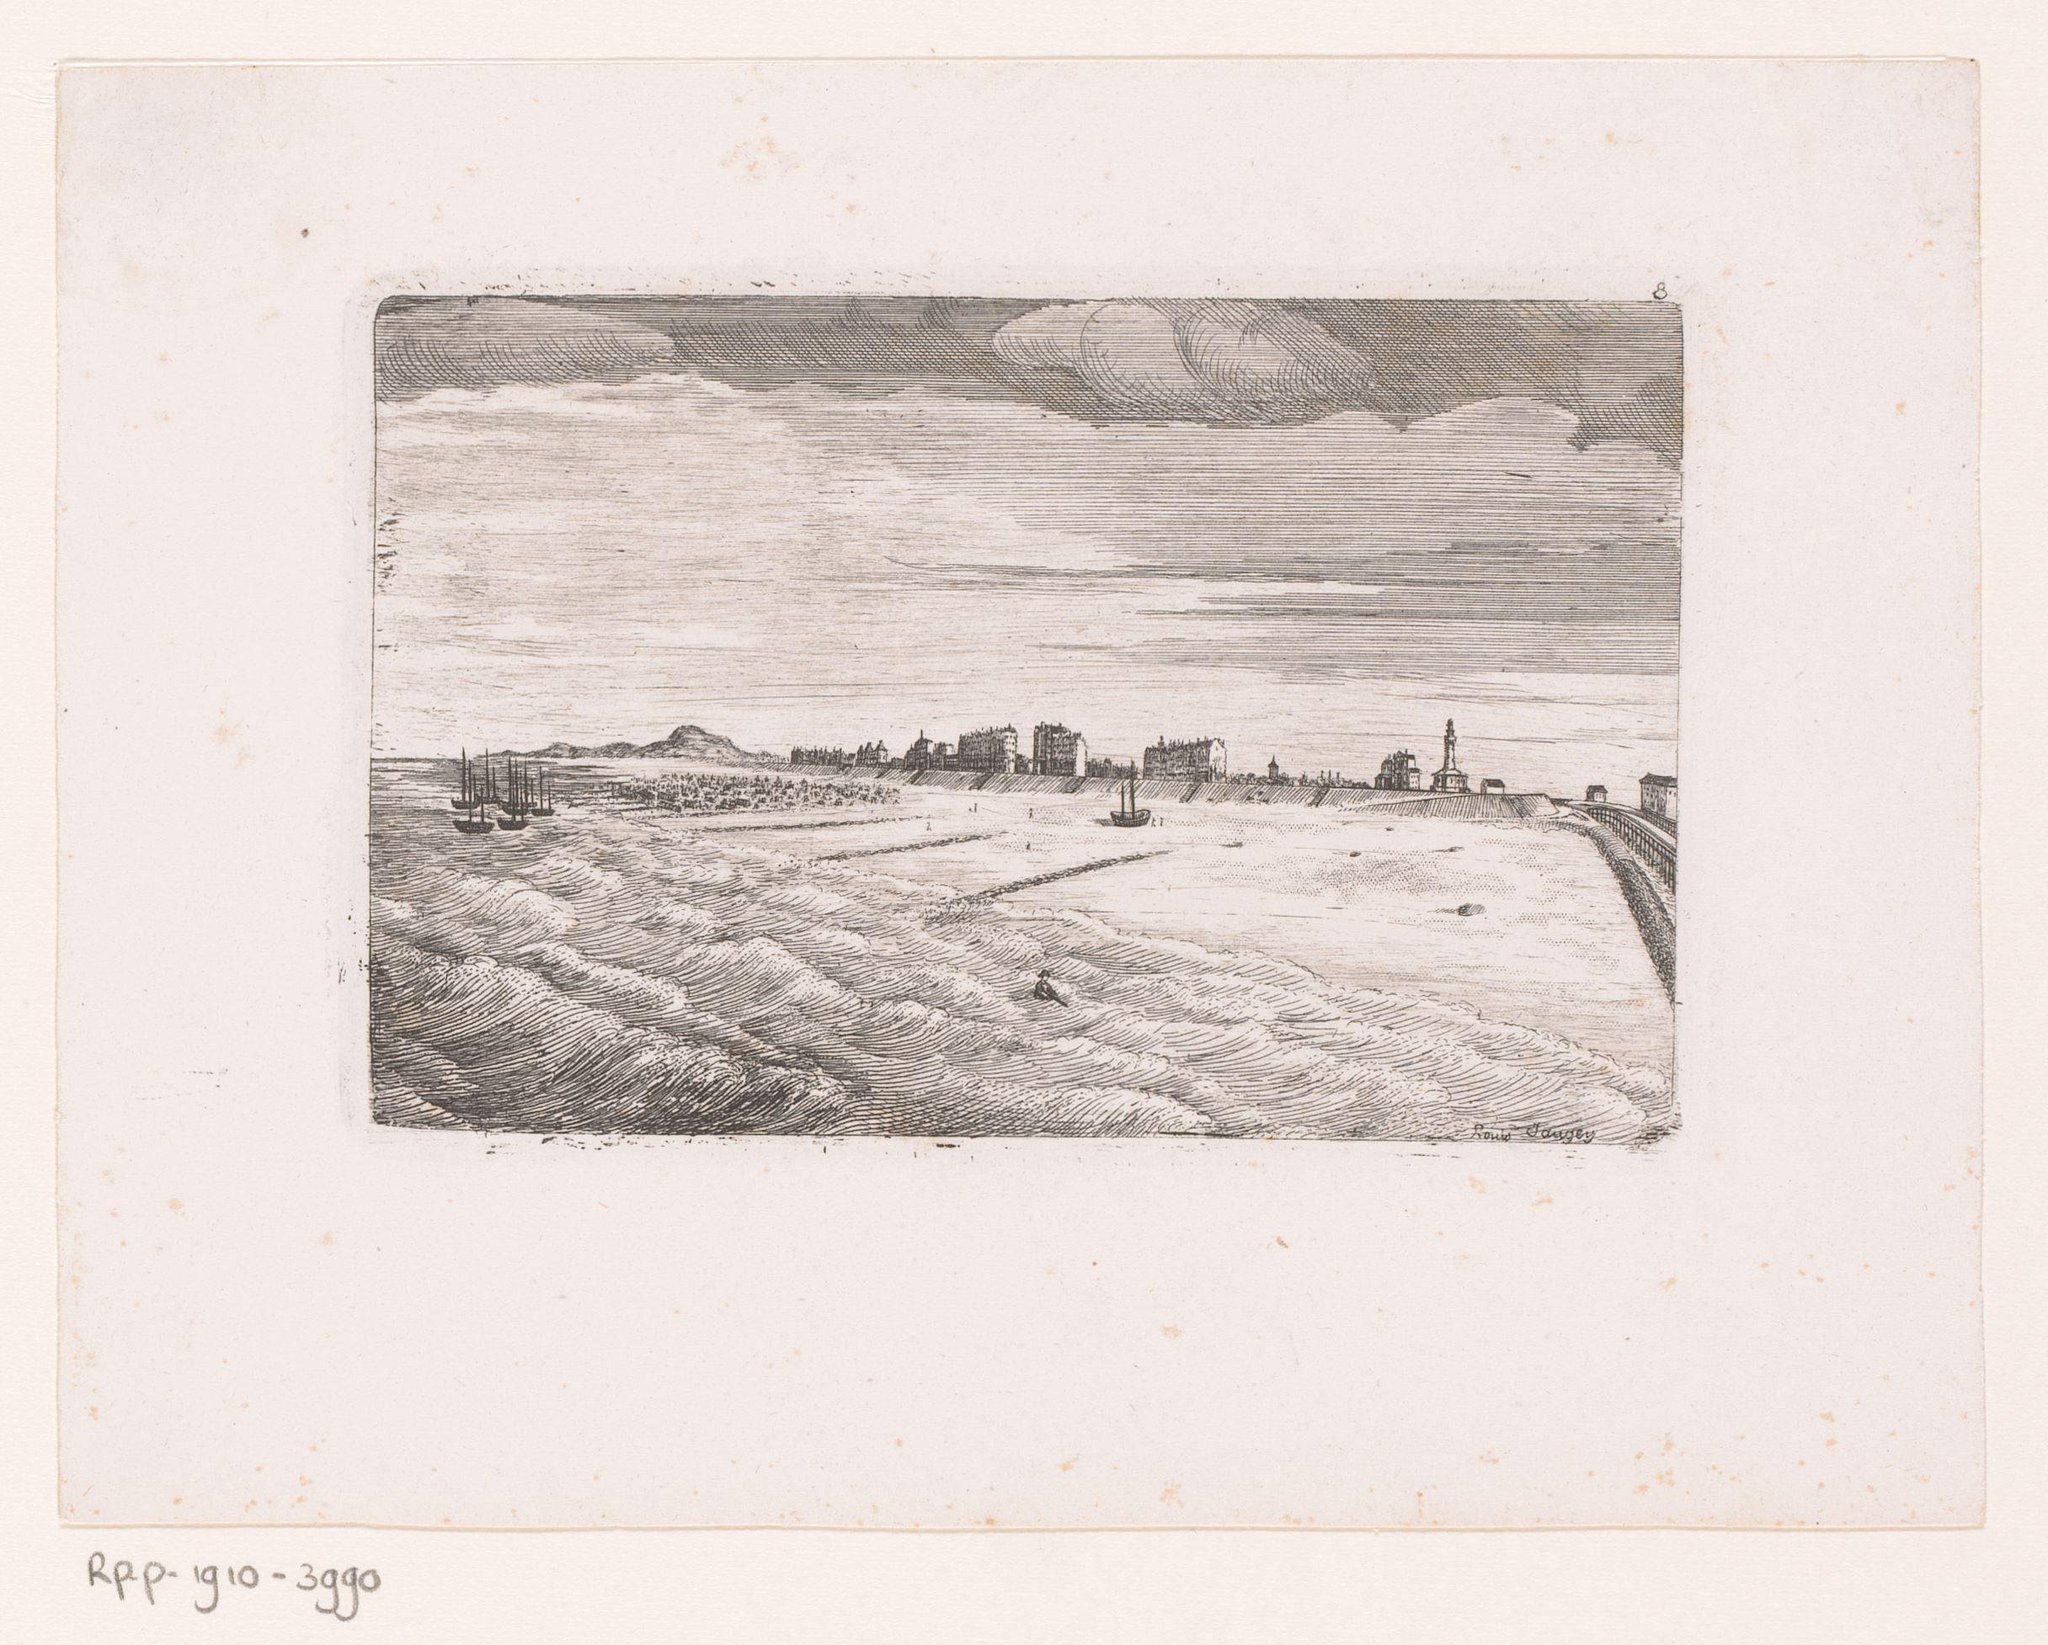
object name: print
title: Souvenir de Blankenberghe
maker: louis jaugey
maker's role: print maker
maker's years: 1837-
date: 1850-1899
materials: paper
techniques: etching, roulette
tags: city-view, and landscape with man-made constructions, sea (seascape)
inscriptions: collector's mark: Lugt 2228